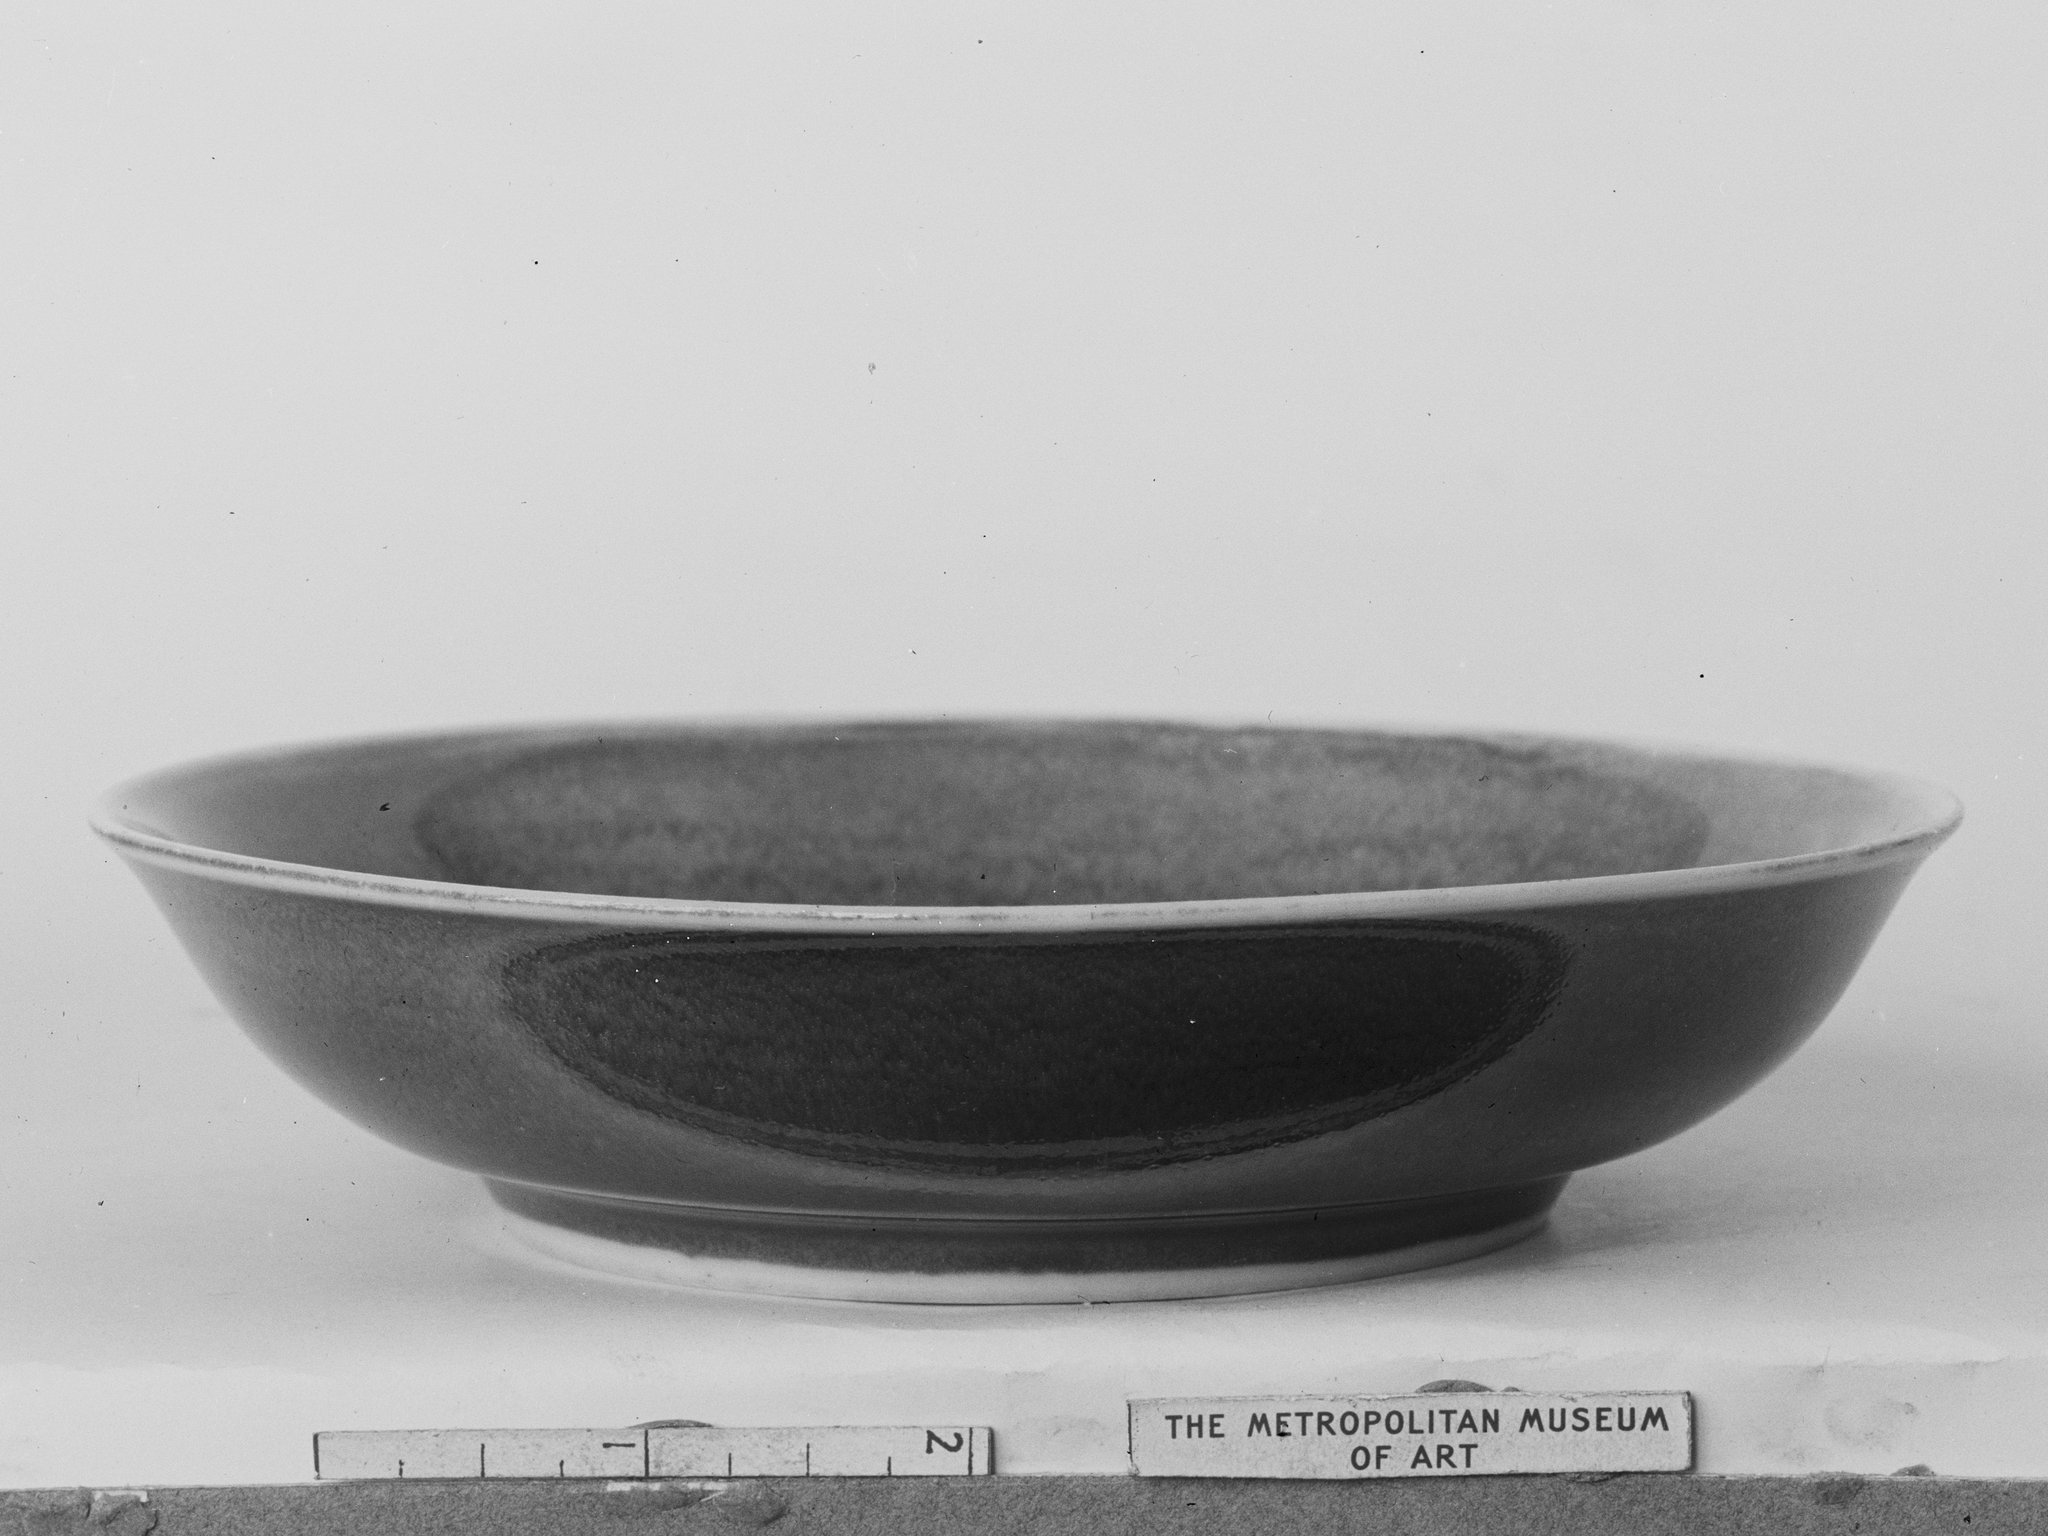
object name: dish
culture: chinese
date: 1426-1435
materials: porcelain